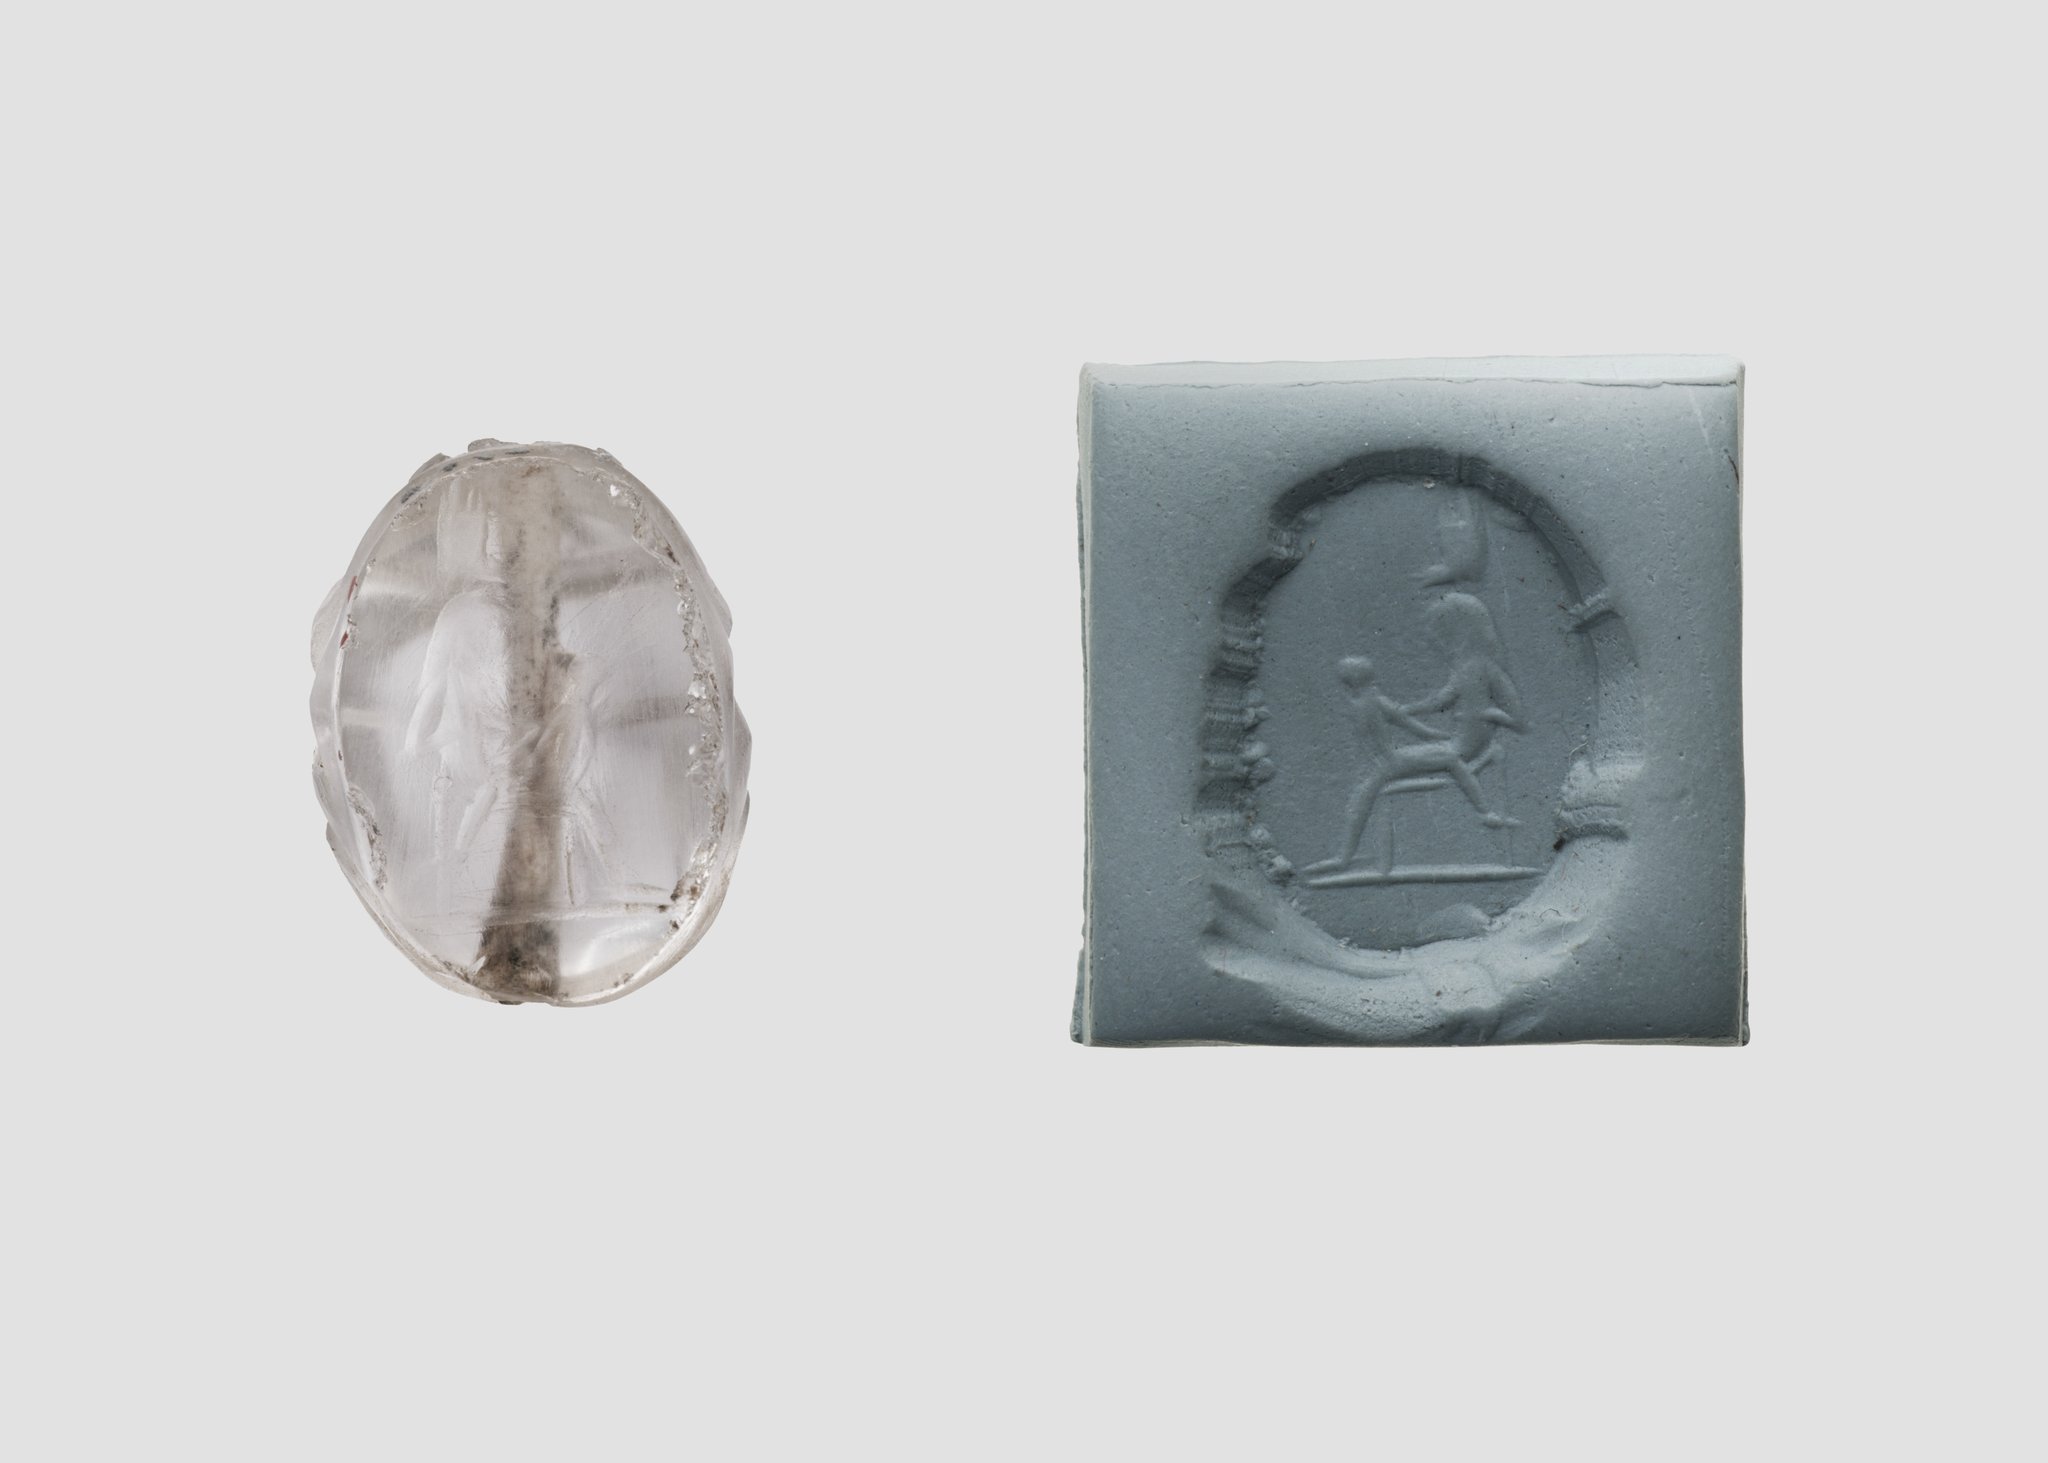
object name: stamp seal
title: Scarab seal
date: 600-501 BCE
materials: quartz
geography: levant or syria